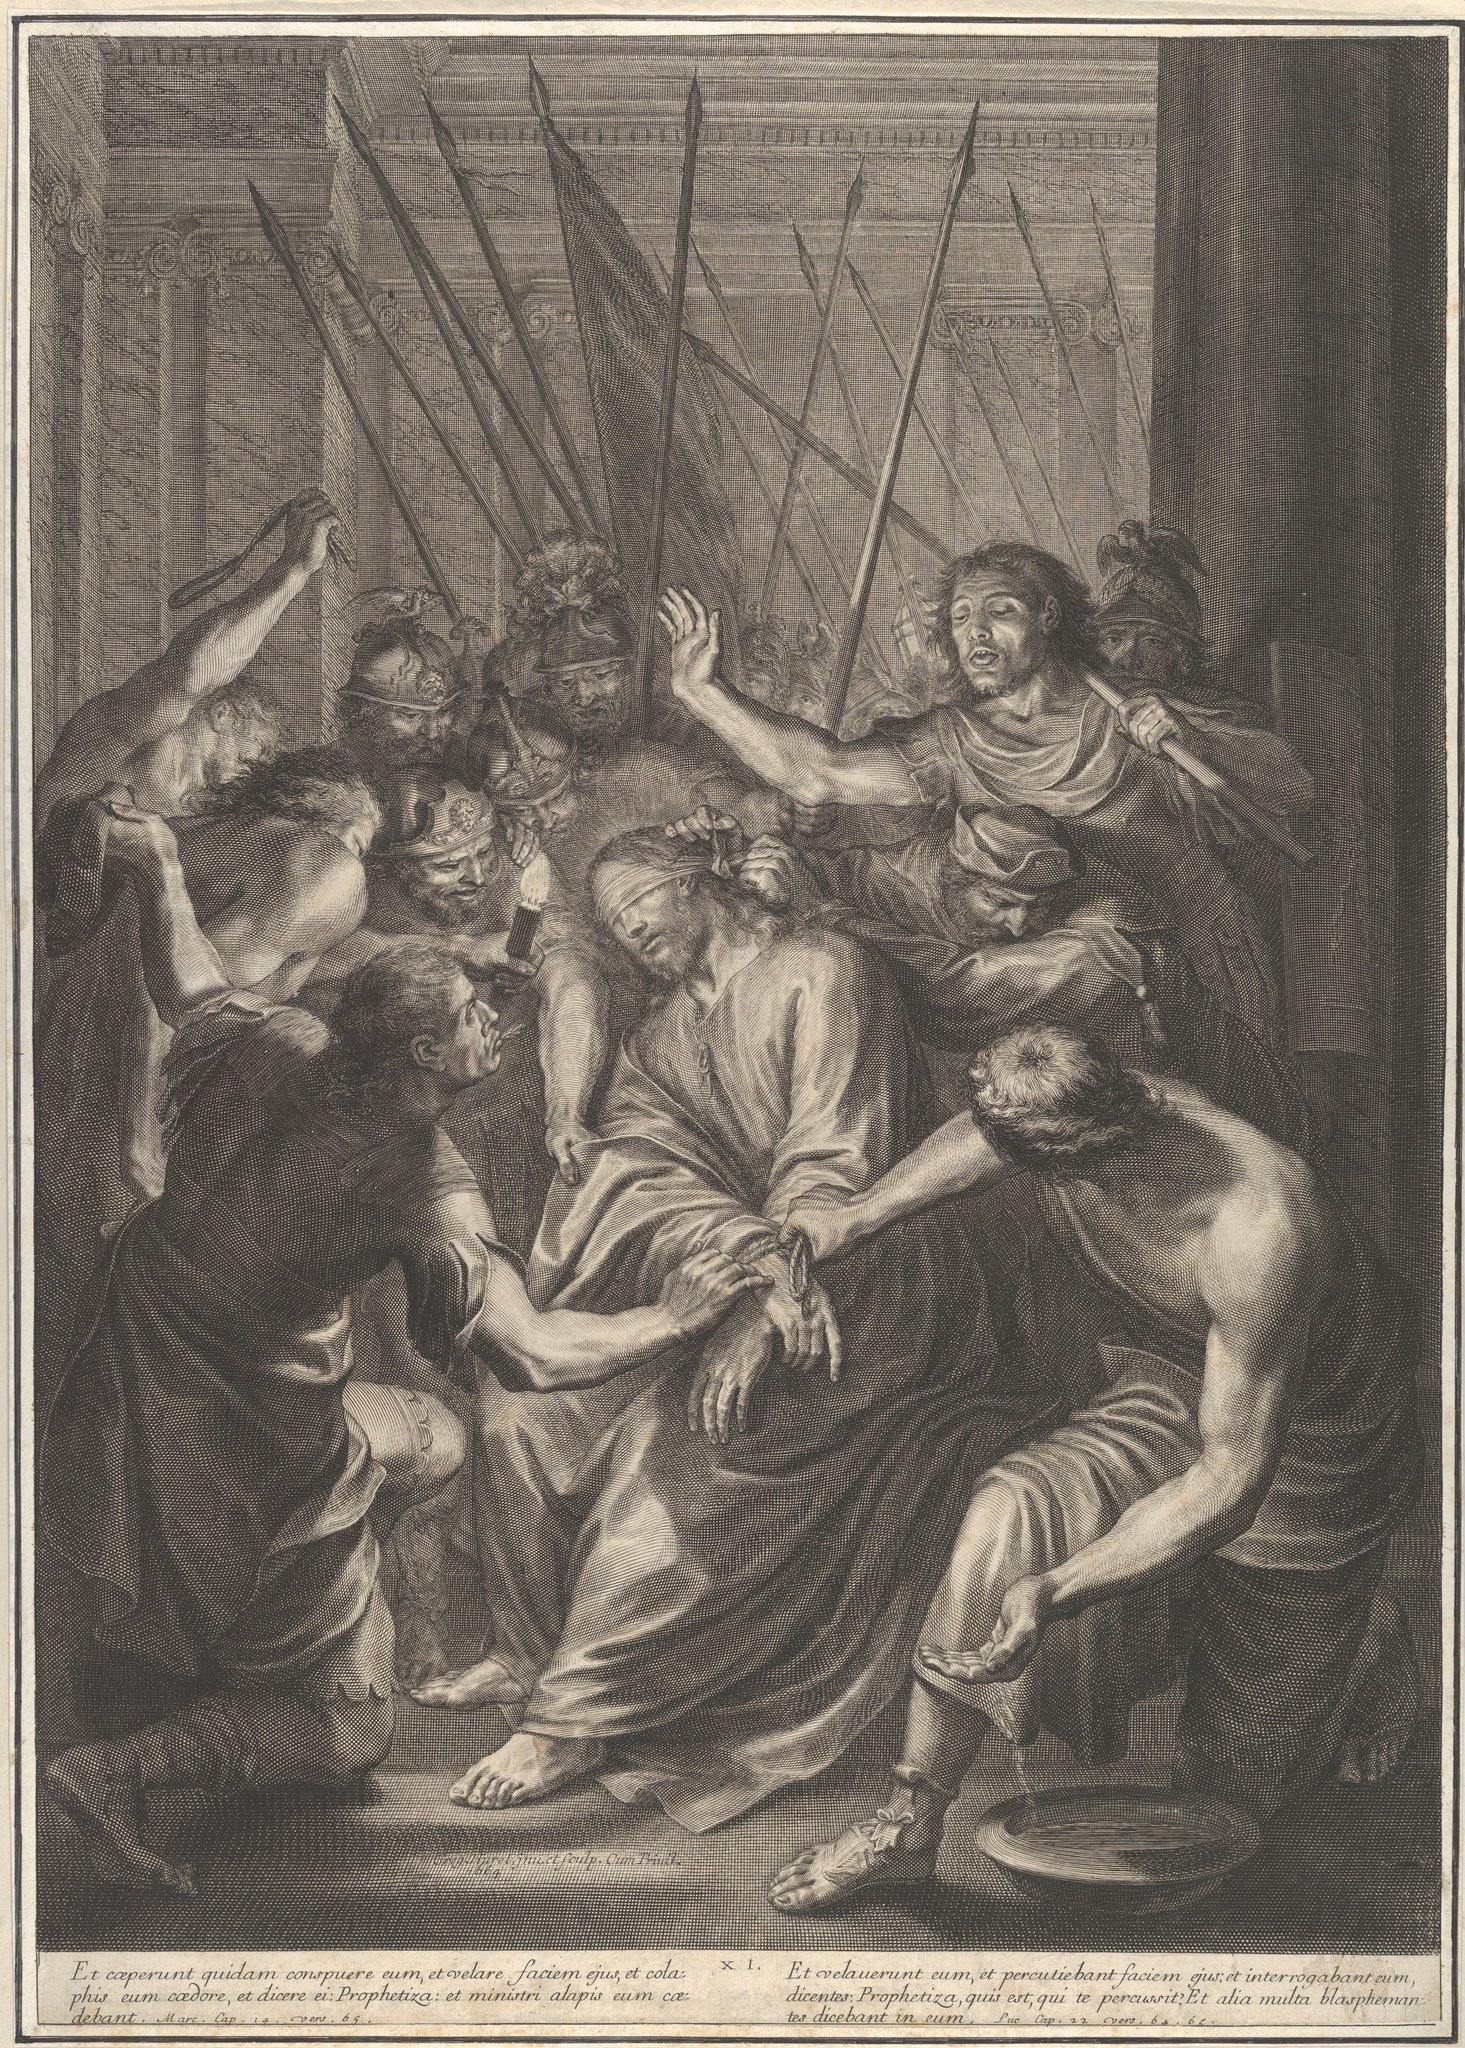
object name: print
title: Christ Mistreated by Guards, from The Passion of Christ, plate 11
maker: grégoire huret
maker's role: artist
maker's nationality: french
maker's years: 1606-1670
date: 1664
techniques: engraving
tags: soldiers,men,christ